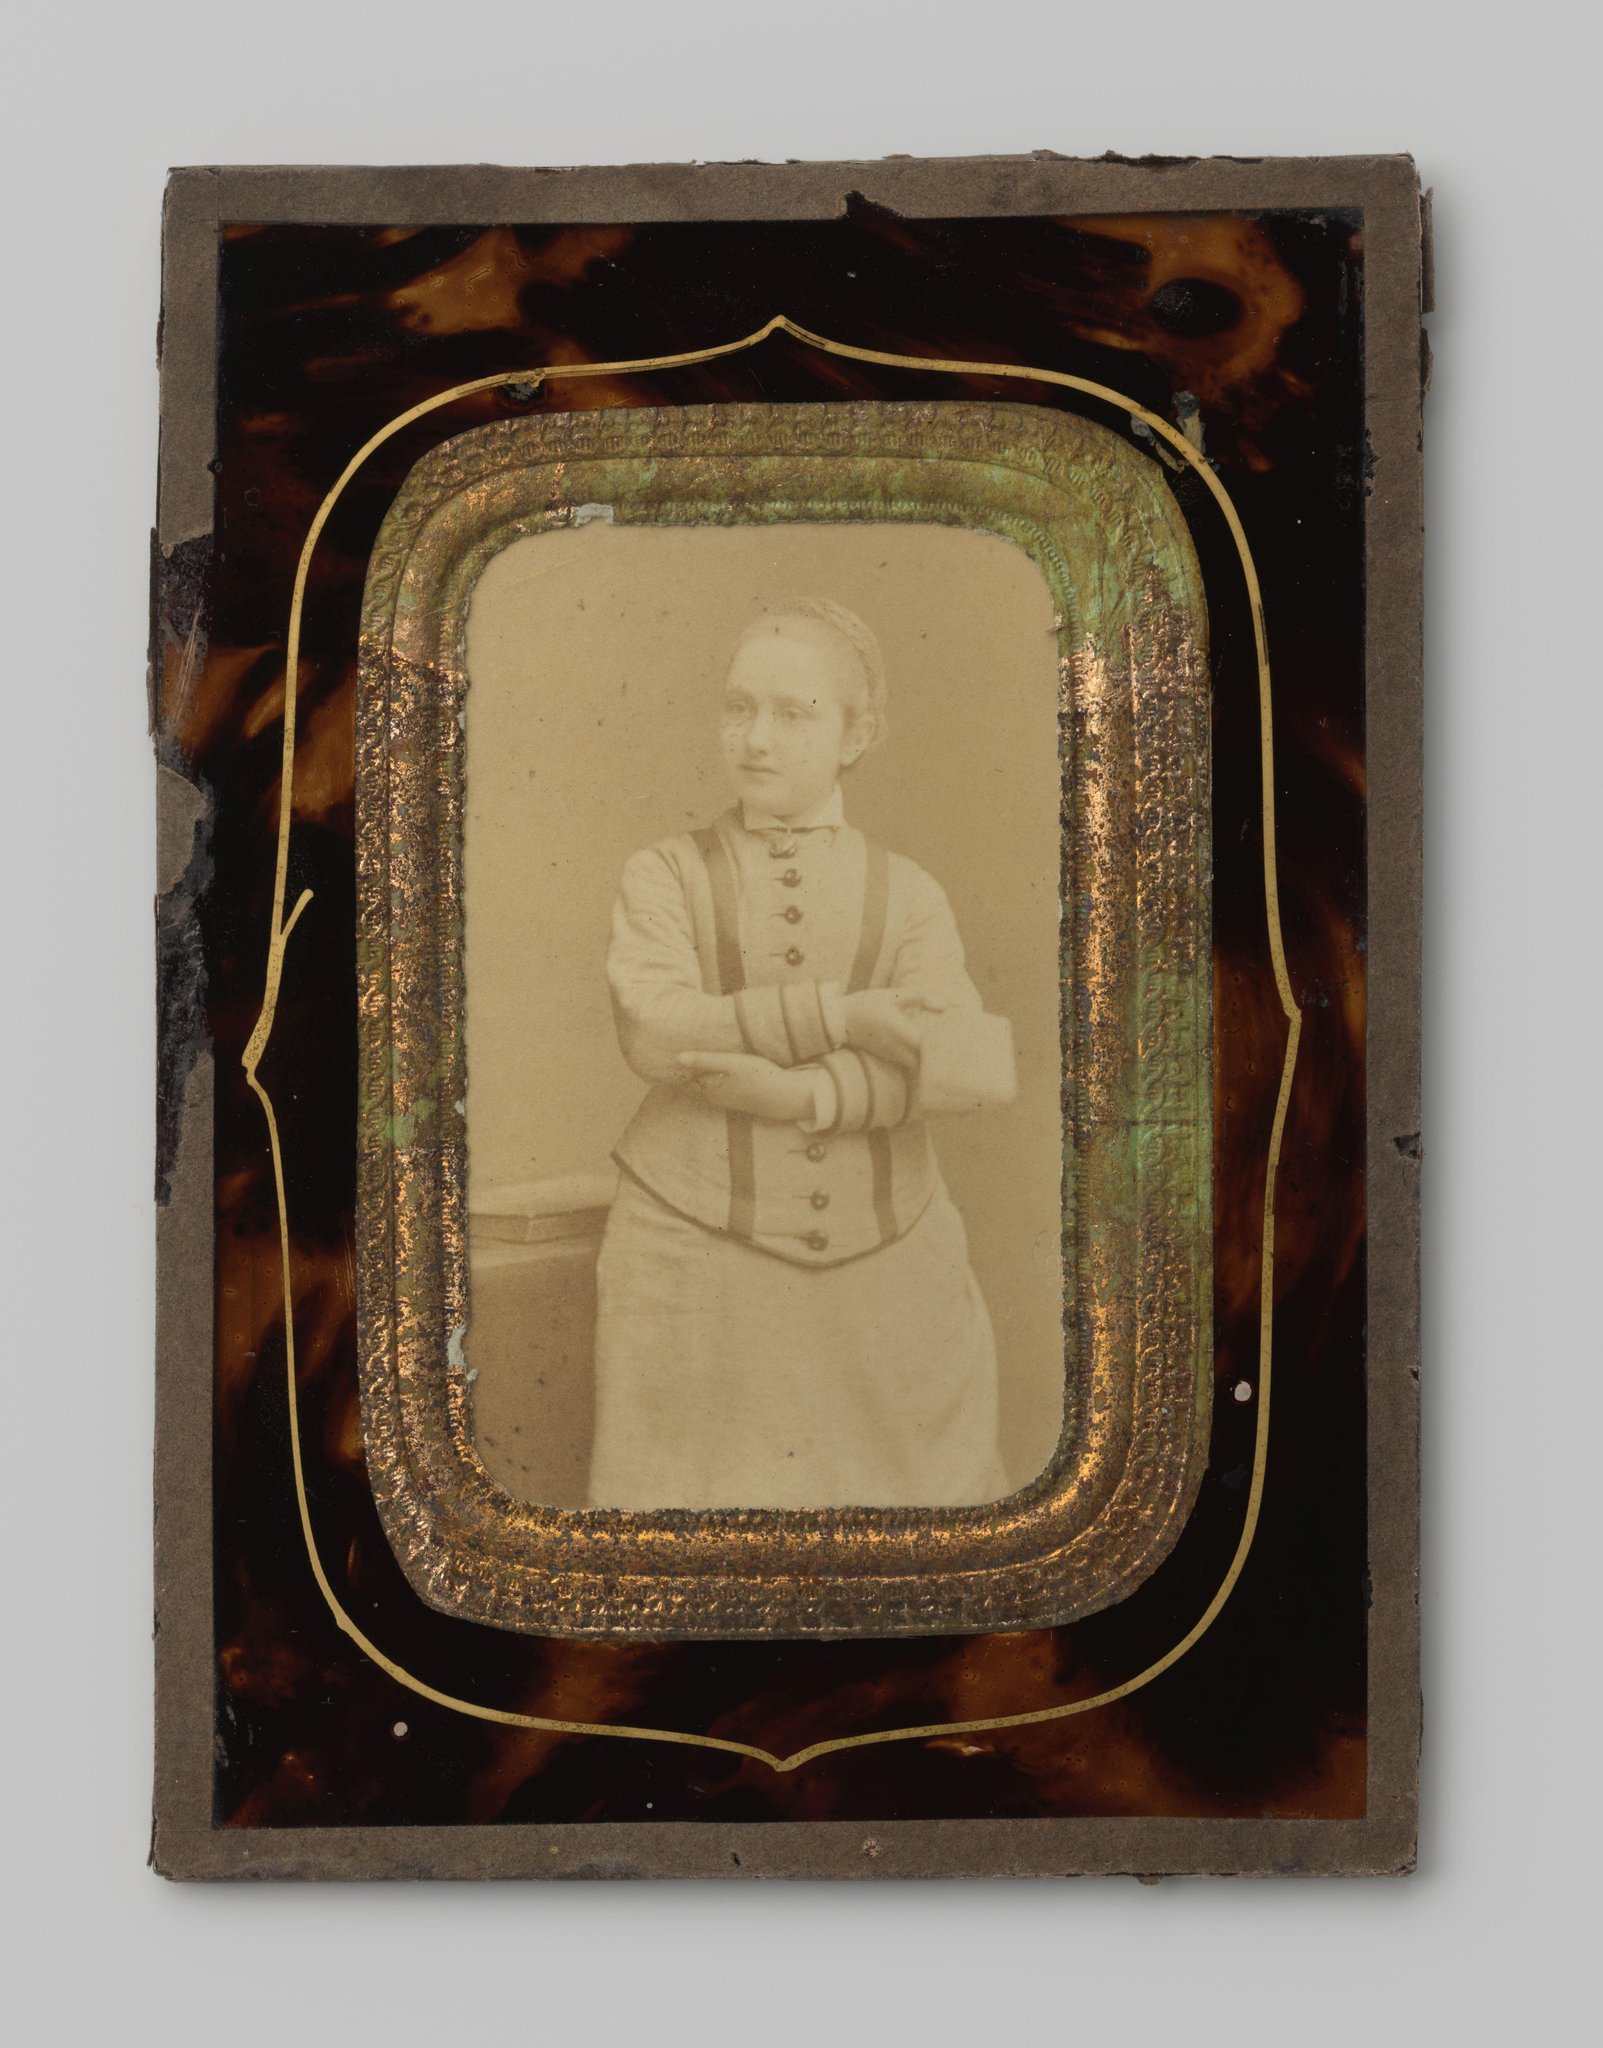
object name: photograph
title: Portret van een onbekende vrouw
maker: Anonymous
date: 1880-1900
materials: cardboard, glass, paper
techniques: albumen print, gilding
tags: adult woman, anonymous historical person portrayed